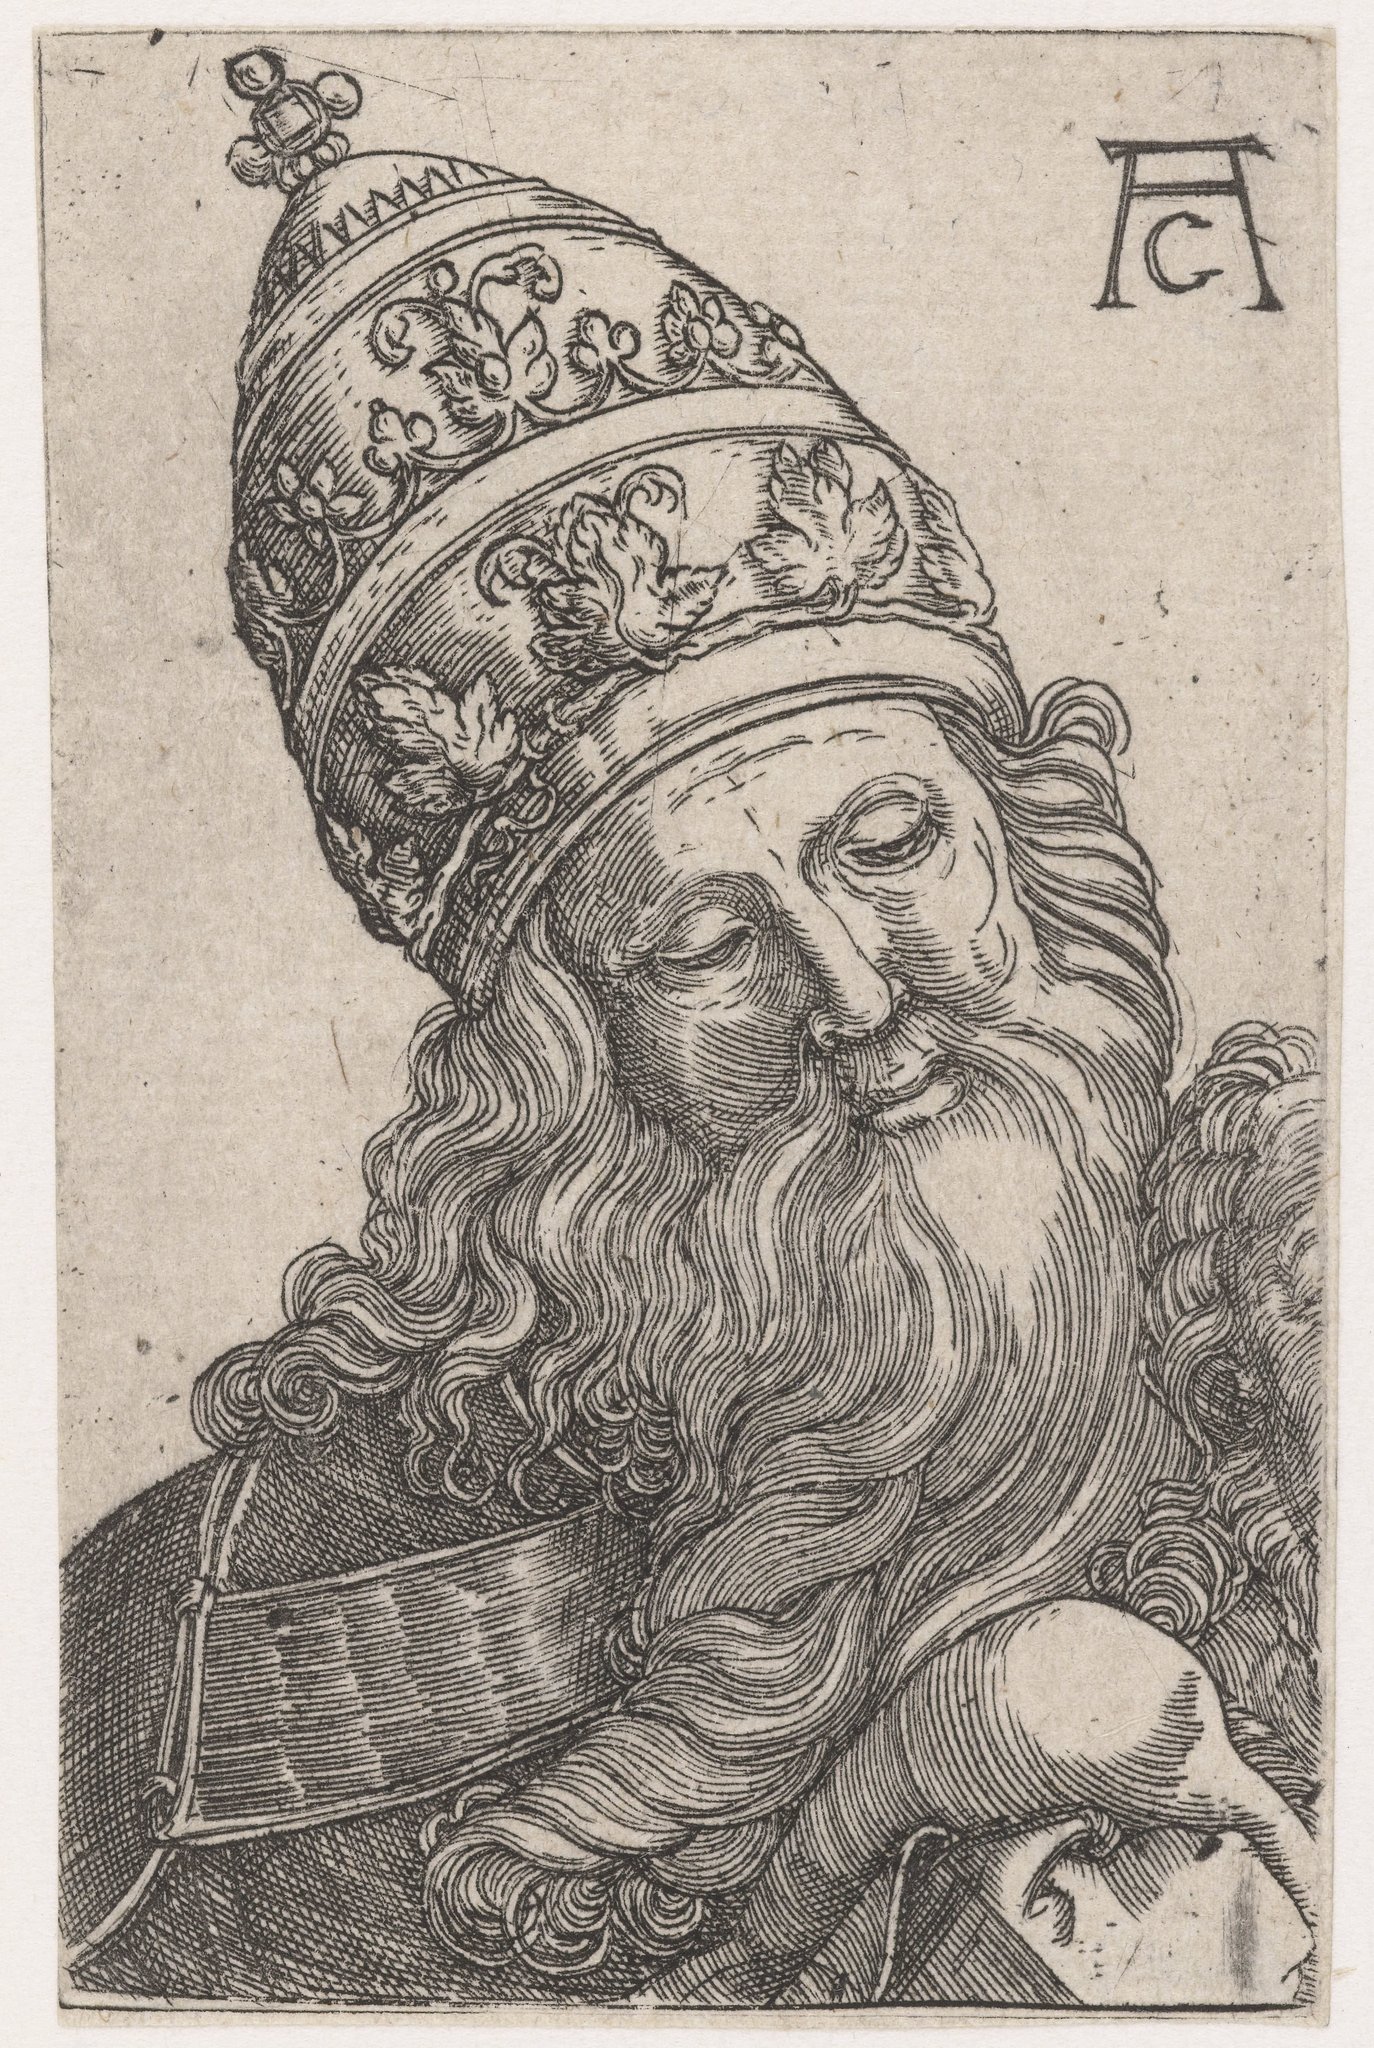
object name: print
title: God de Vader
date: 1520-1562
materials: paper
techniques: engraving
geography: low countries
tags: god the father as bearded old man, usually with crown or tiara or sceptre and/or globe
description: God de Vader met tiara, tegen linker schouder leunt tweede persoon (Christus?).